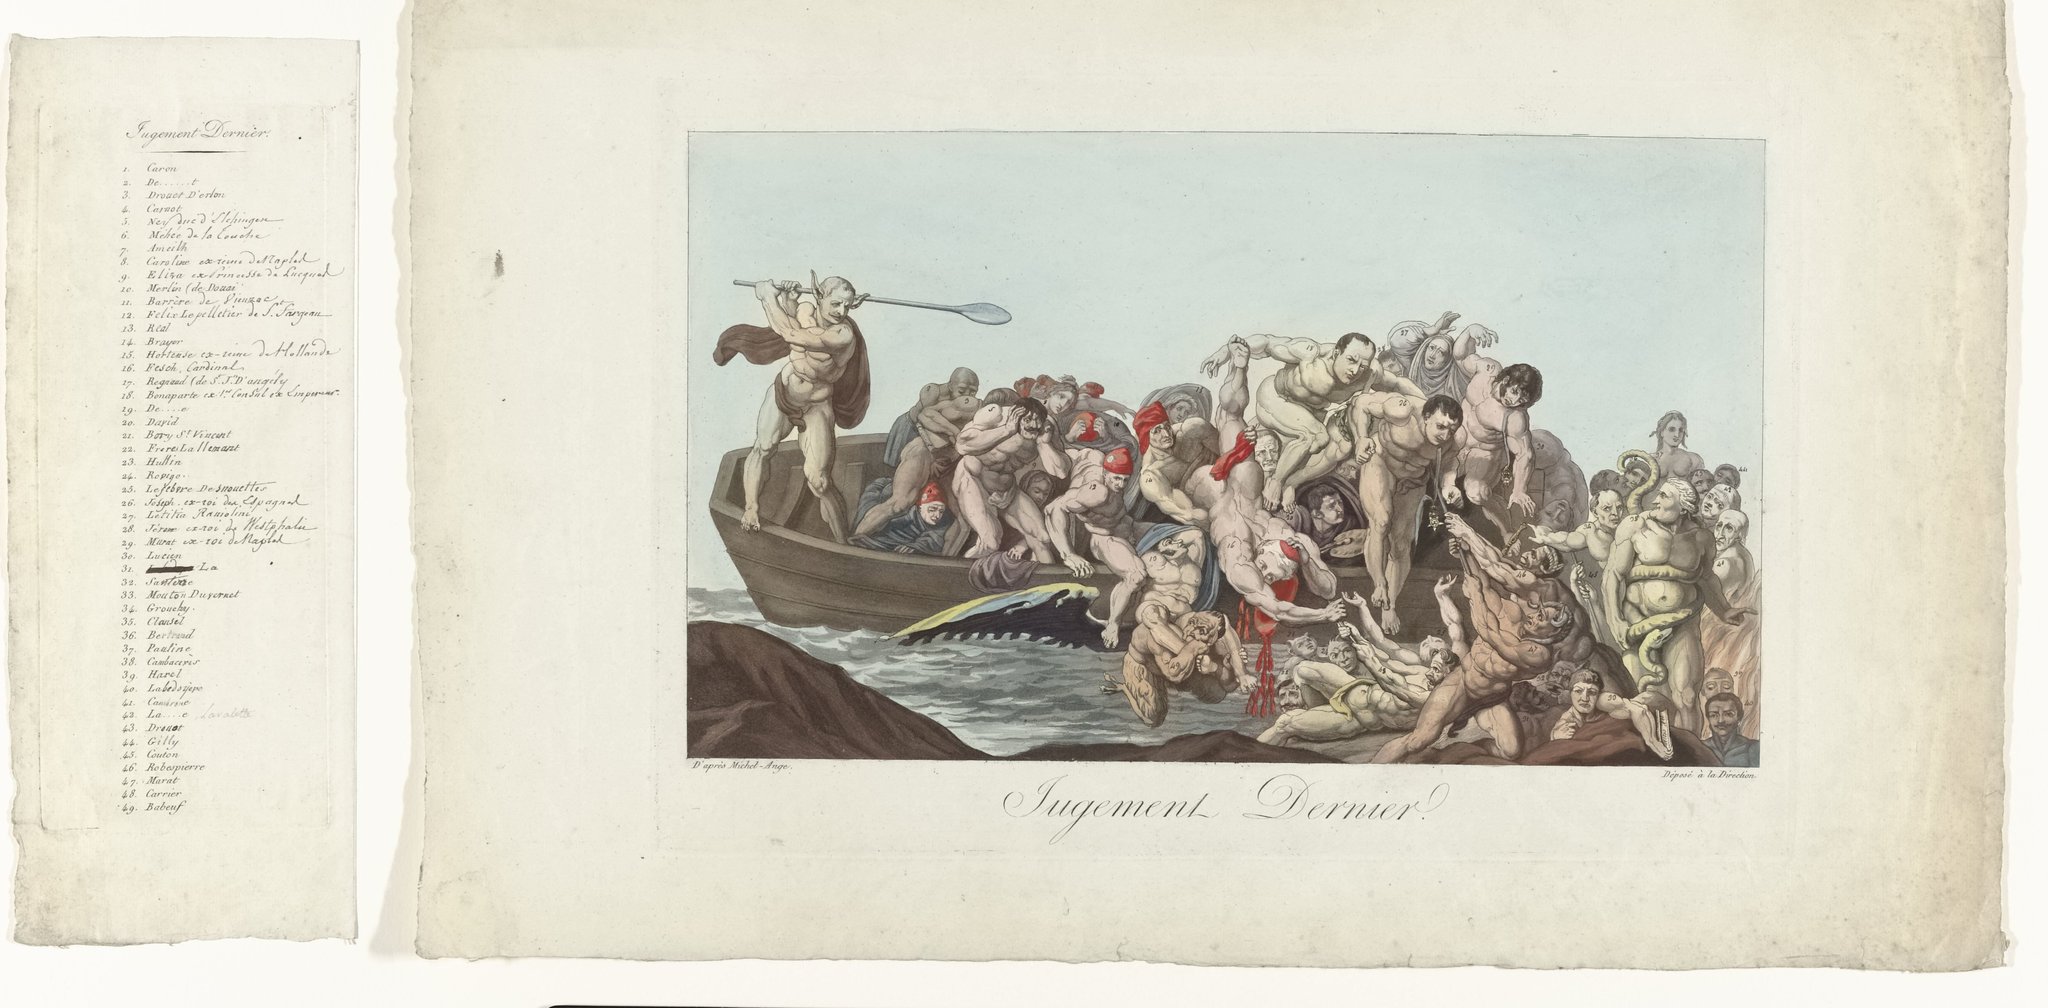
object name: print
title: Jugement Dernier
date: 1815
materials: paper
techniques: aquatint, etching, hand coloring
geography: vatican city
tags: rome, napoleon i (emperor of the french), paris, last judgement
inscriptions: collector's mark: Lugt 2228, collector's mark: Lugt 2760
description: Allegorie op de ondergang van de Franse Revolutie en de val van Napoleon geïnspireerd op het 'Laatste Oordeel' van Michelangelo met daarin verwerkt negenenveertig personages uit het bestuurlijke, politieke en artistieke leven. De figuren zijn voorzien van een nummering in pen corresponderend met een bijgeleverde legenda met een deels gedrukte, deels handgeschreven lijst namen. Tot de afgebeelde figuren behoren ondermeer 'Bonaparte', ''Murat'', 'Fesch Cardinal' en 'Hortense ex-reine de Hollande'.